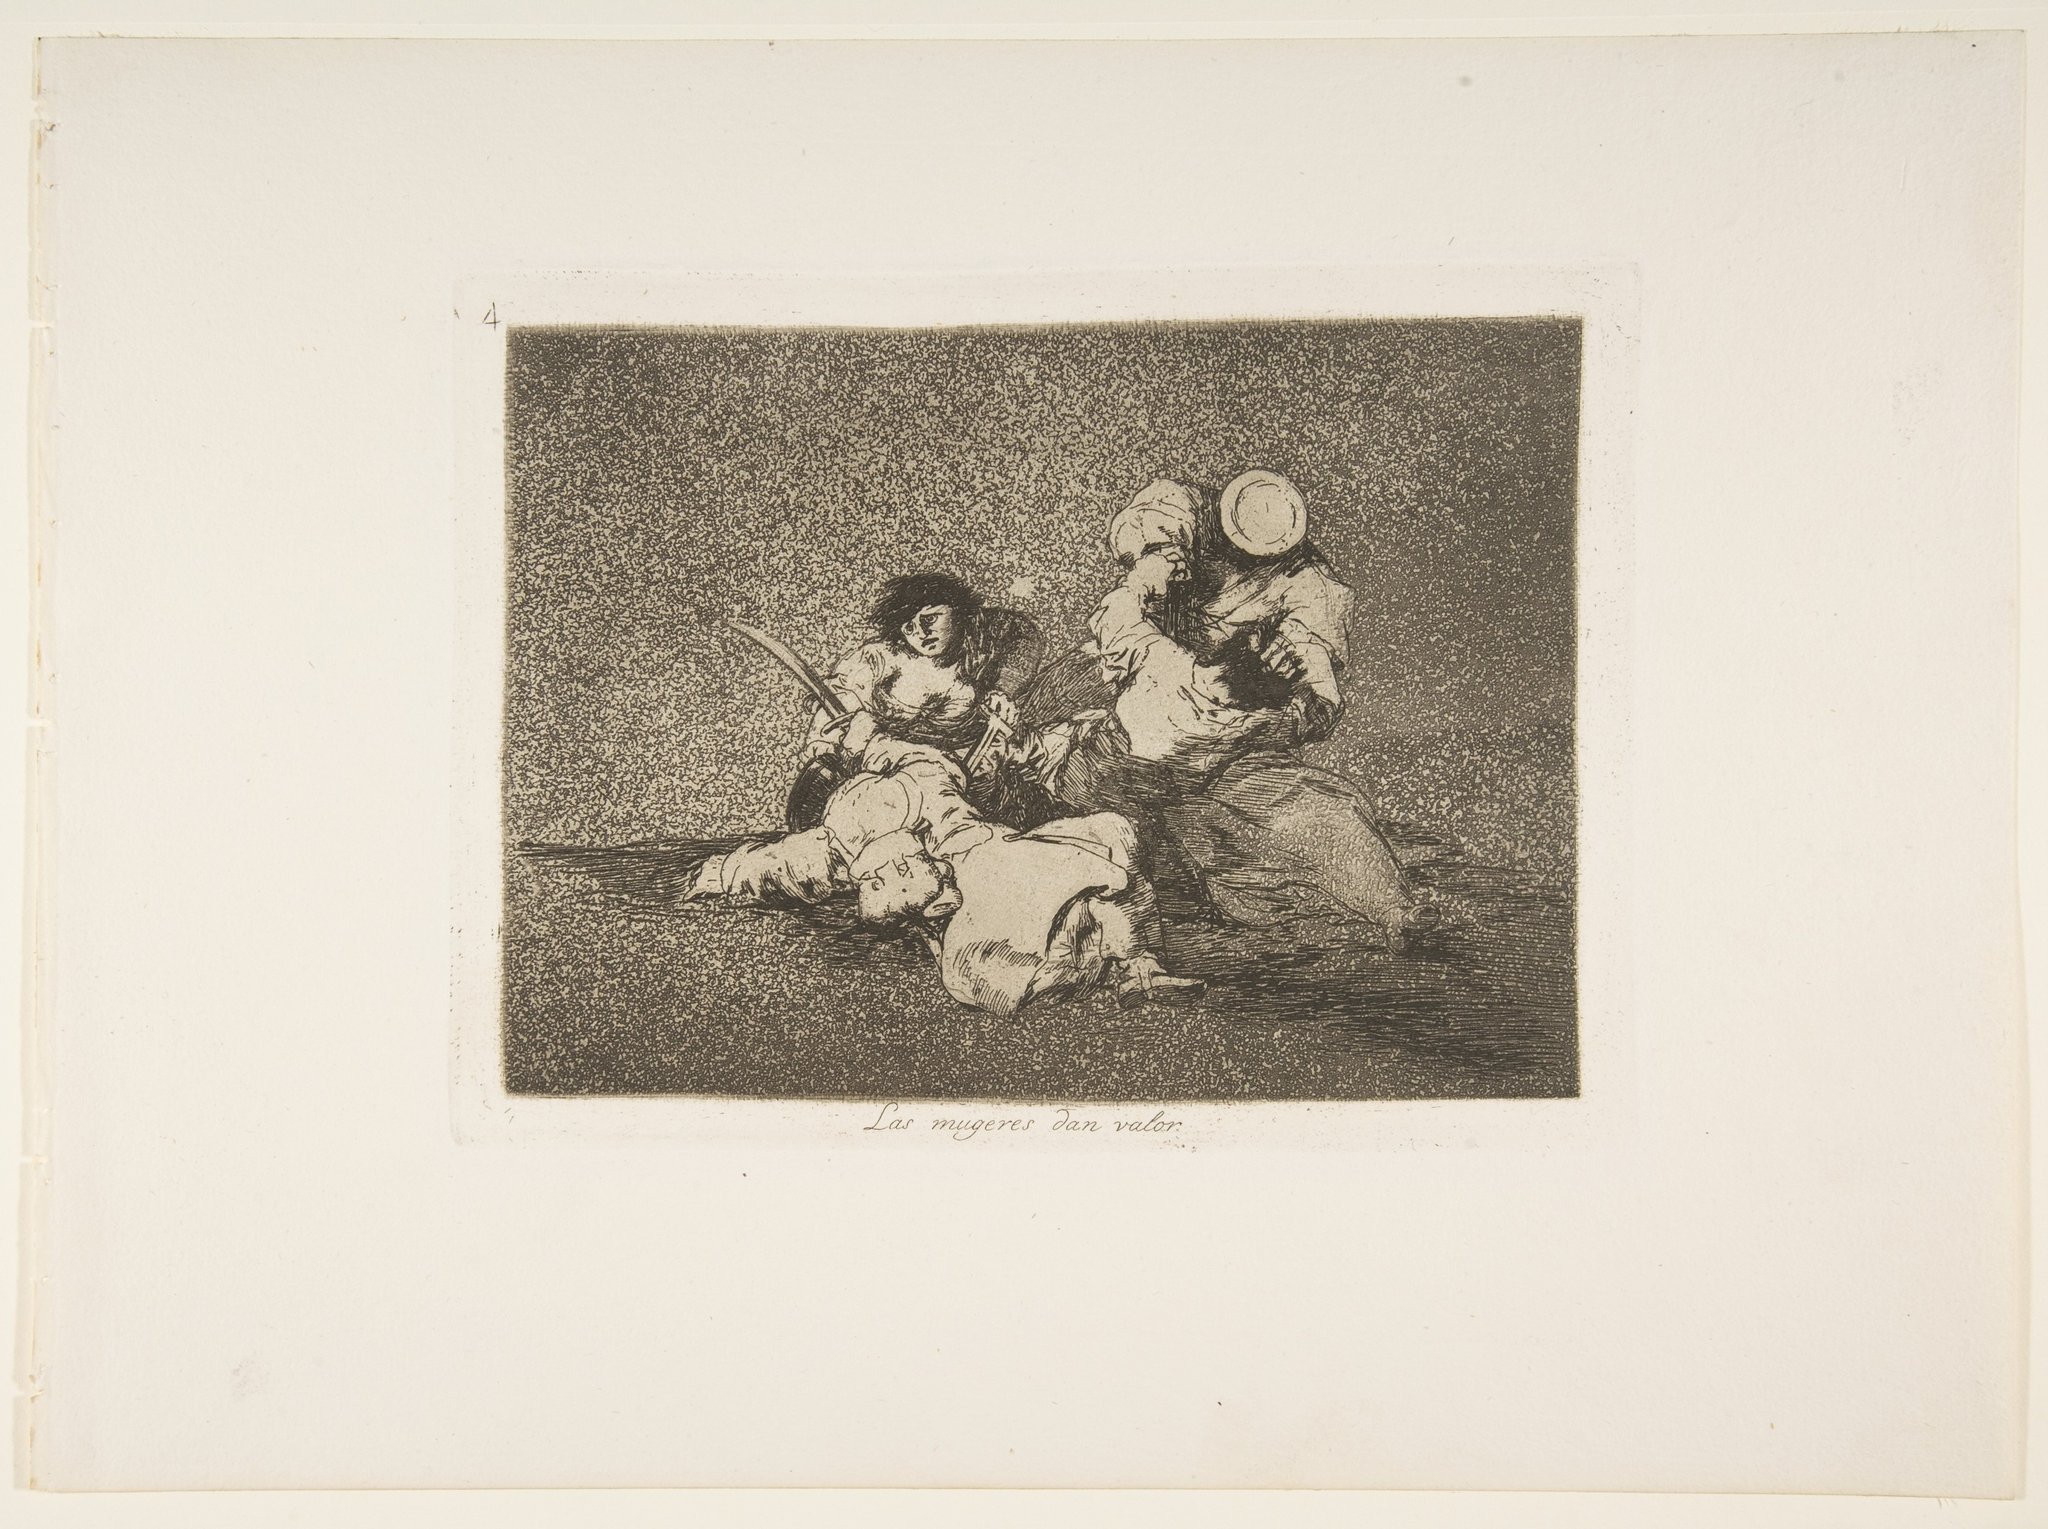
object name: print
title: Plate 4 from "The Disasters of War" (Los Desastres de la Guerra): 'The women give courage' (Las mugeres dan valor)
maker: goya (francisco de goya y lucientes)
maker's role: artist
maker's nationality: spanish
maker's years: 1746-1828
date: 1810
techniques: aquatint, drypoint, etching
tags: men,women